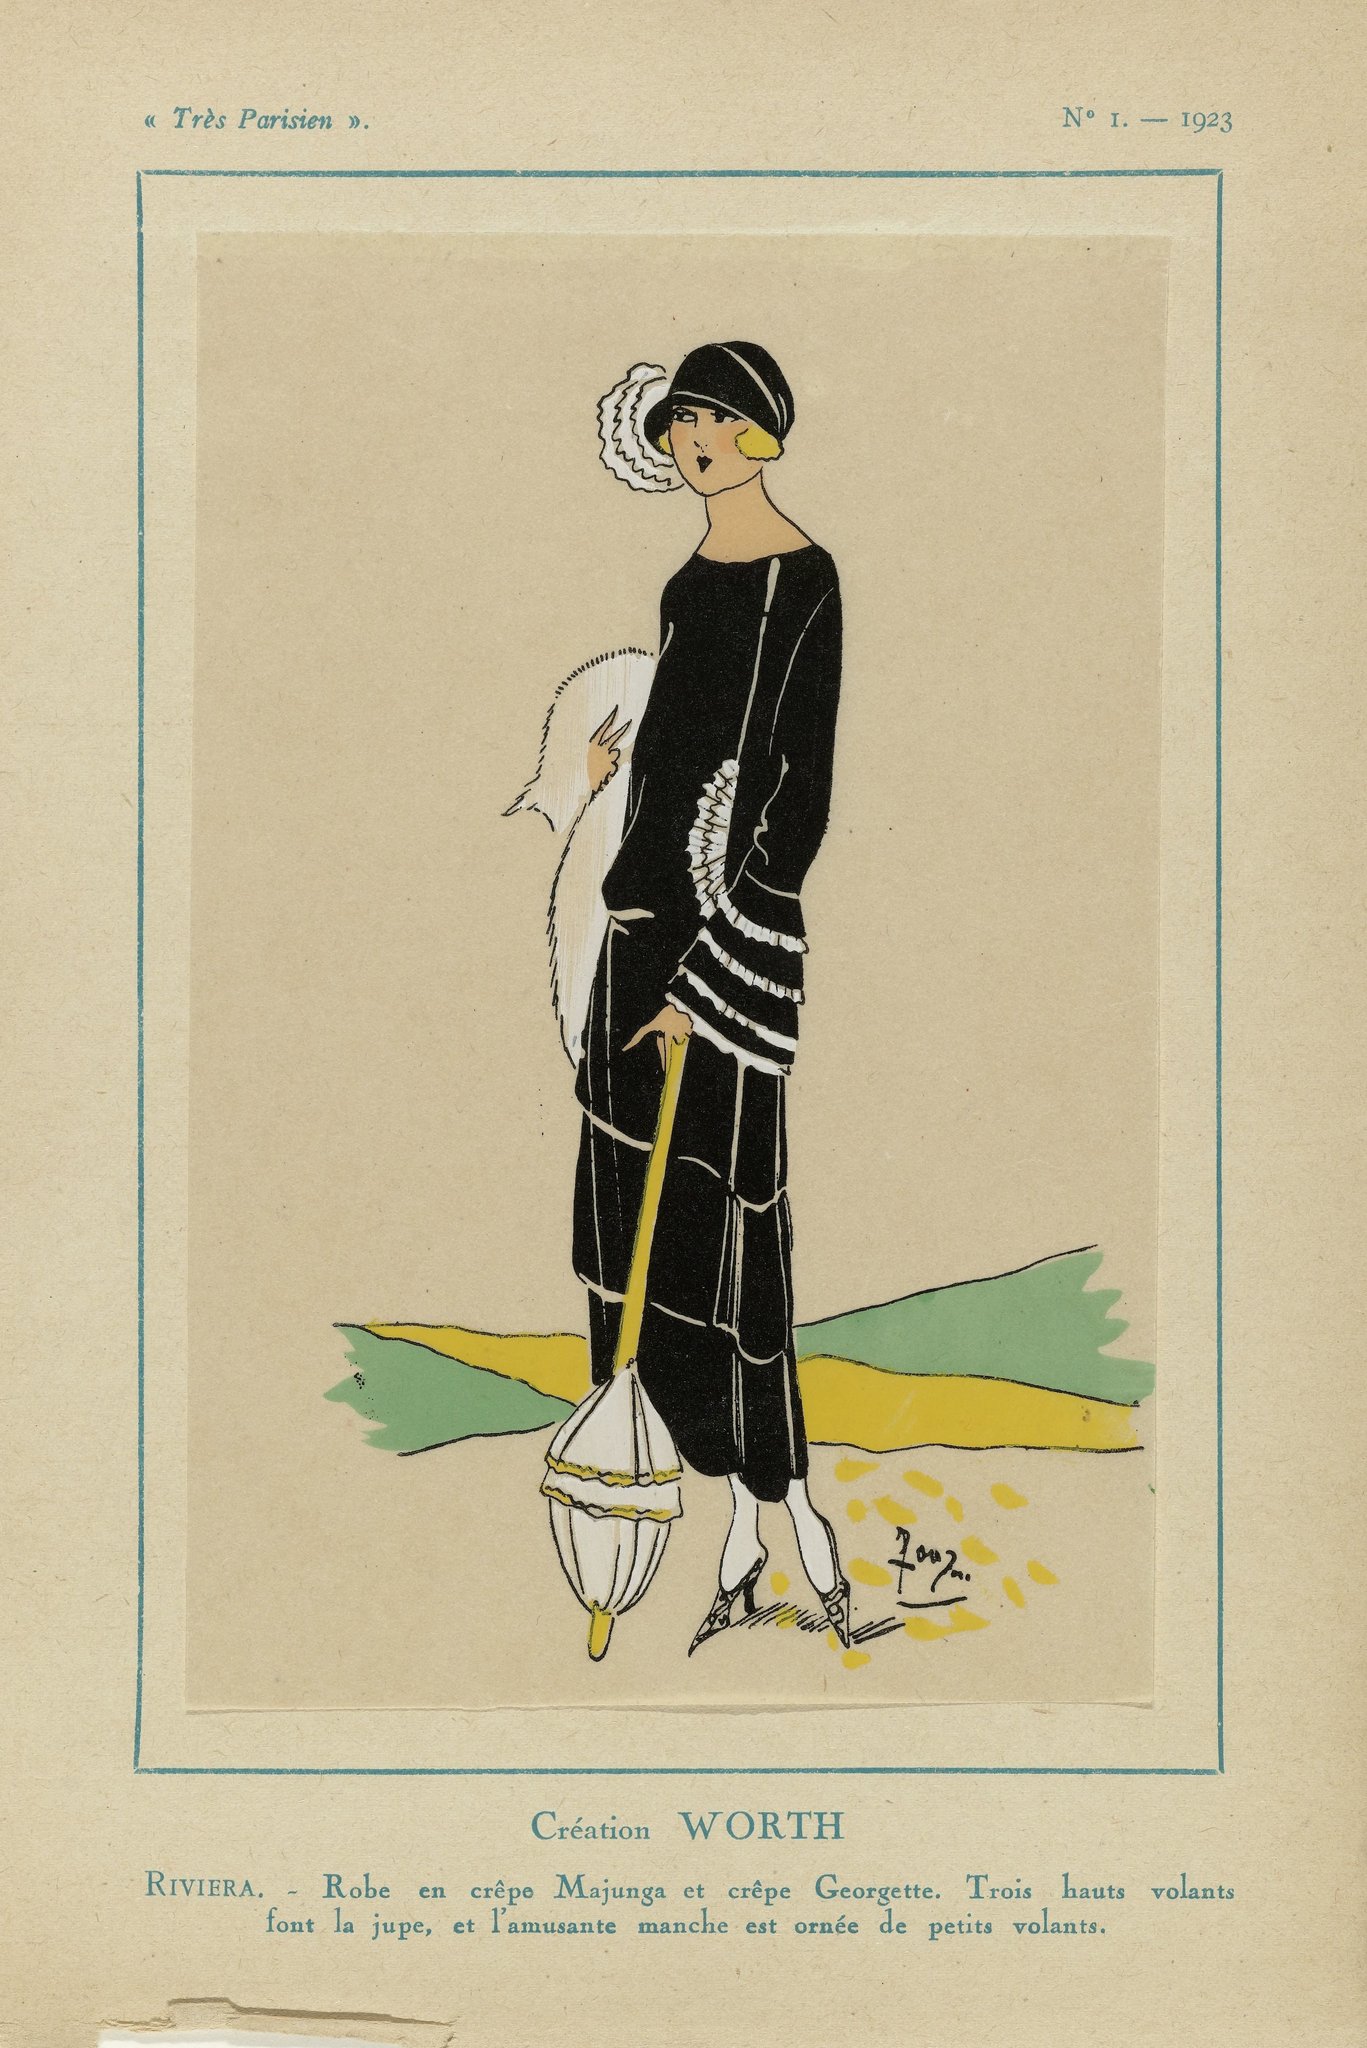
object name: fashion print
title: Très Parisien, 1923, No 1: Création WORTH...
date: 1923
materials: paper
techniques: hand coloring, letterpress printing, lithography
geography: paris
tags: walking-stick, staff, cane (+ women's clothes), fashion plates, clothes, costume (+ women's clothes), dress, gown (+ women's clothes), clothing for the upper part of the body (shawl) (+ fur used for clothes)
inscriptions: title: ‘Très Parisien / No 1. - 1923’, caption: ‘Création WORTH / RIVIERA. - Robe en crêpe Majunga et crêpe Georgette. Trois hauts volants font la jupe, et l'amusante manche est ornée de petits volants.’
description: Japon van Worth van crêpe Majunga en crêpe Georgette met drie stroken op de rok en grote manchetten met stroken. Prent uit het modetijdschrift Très Parisien (1920-1936).